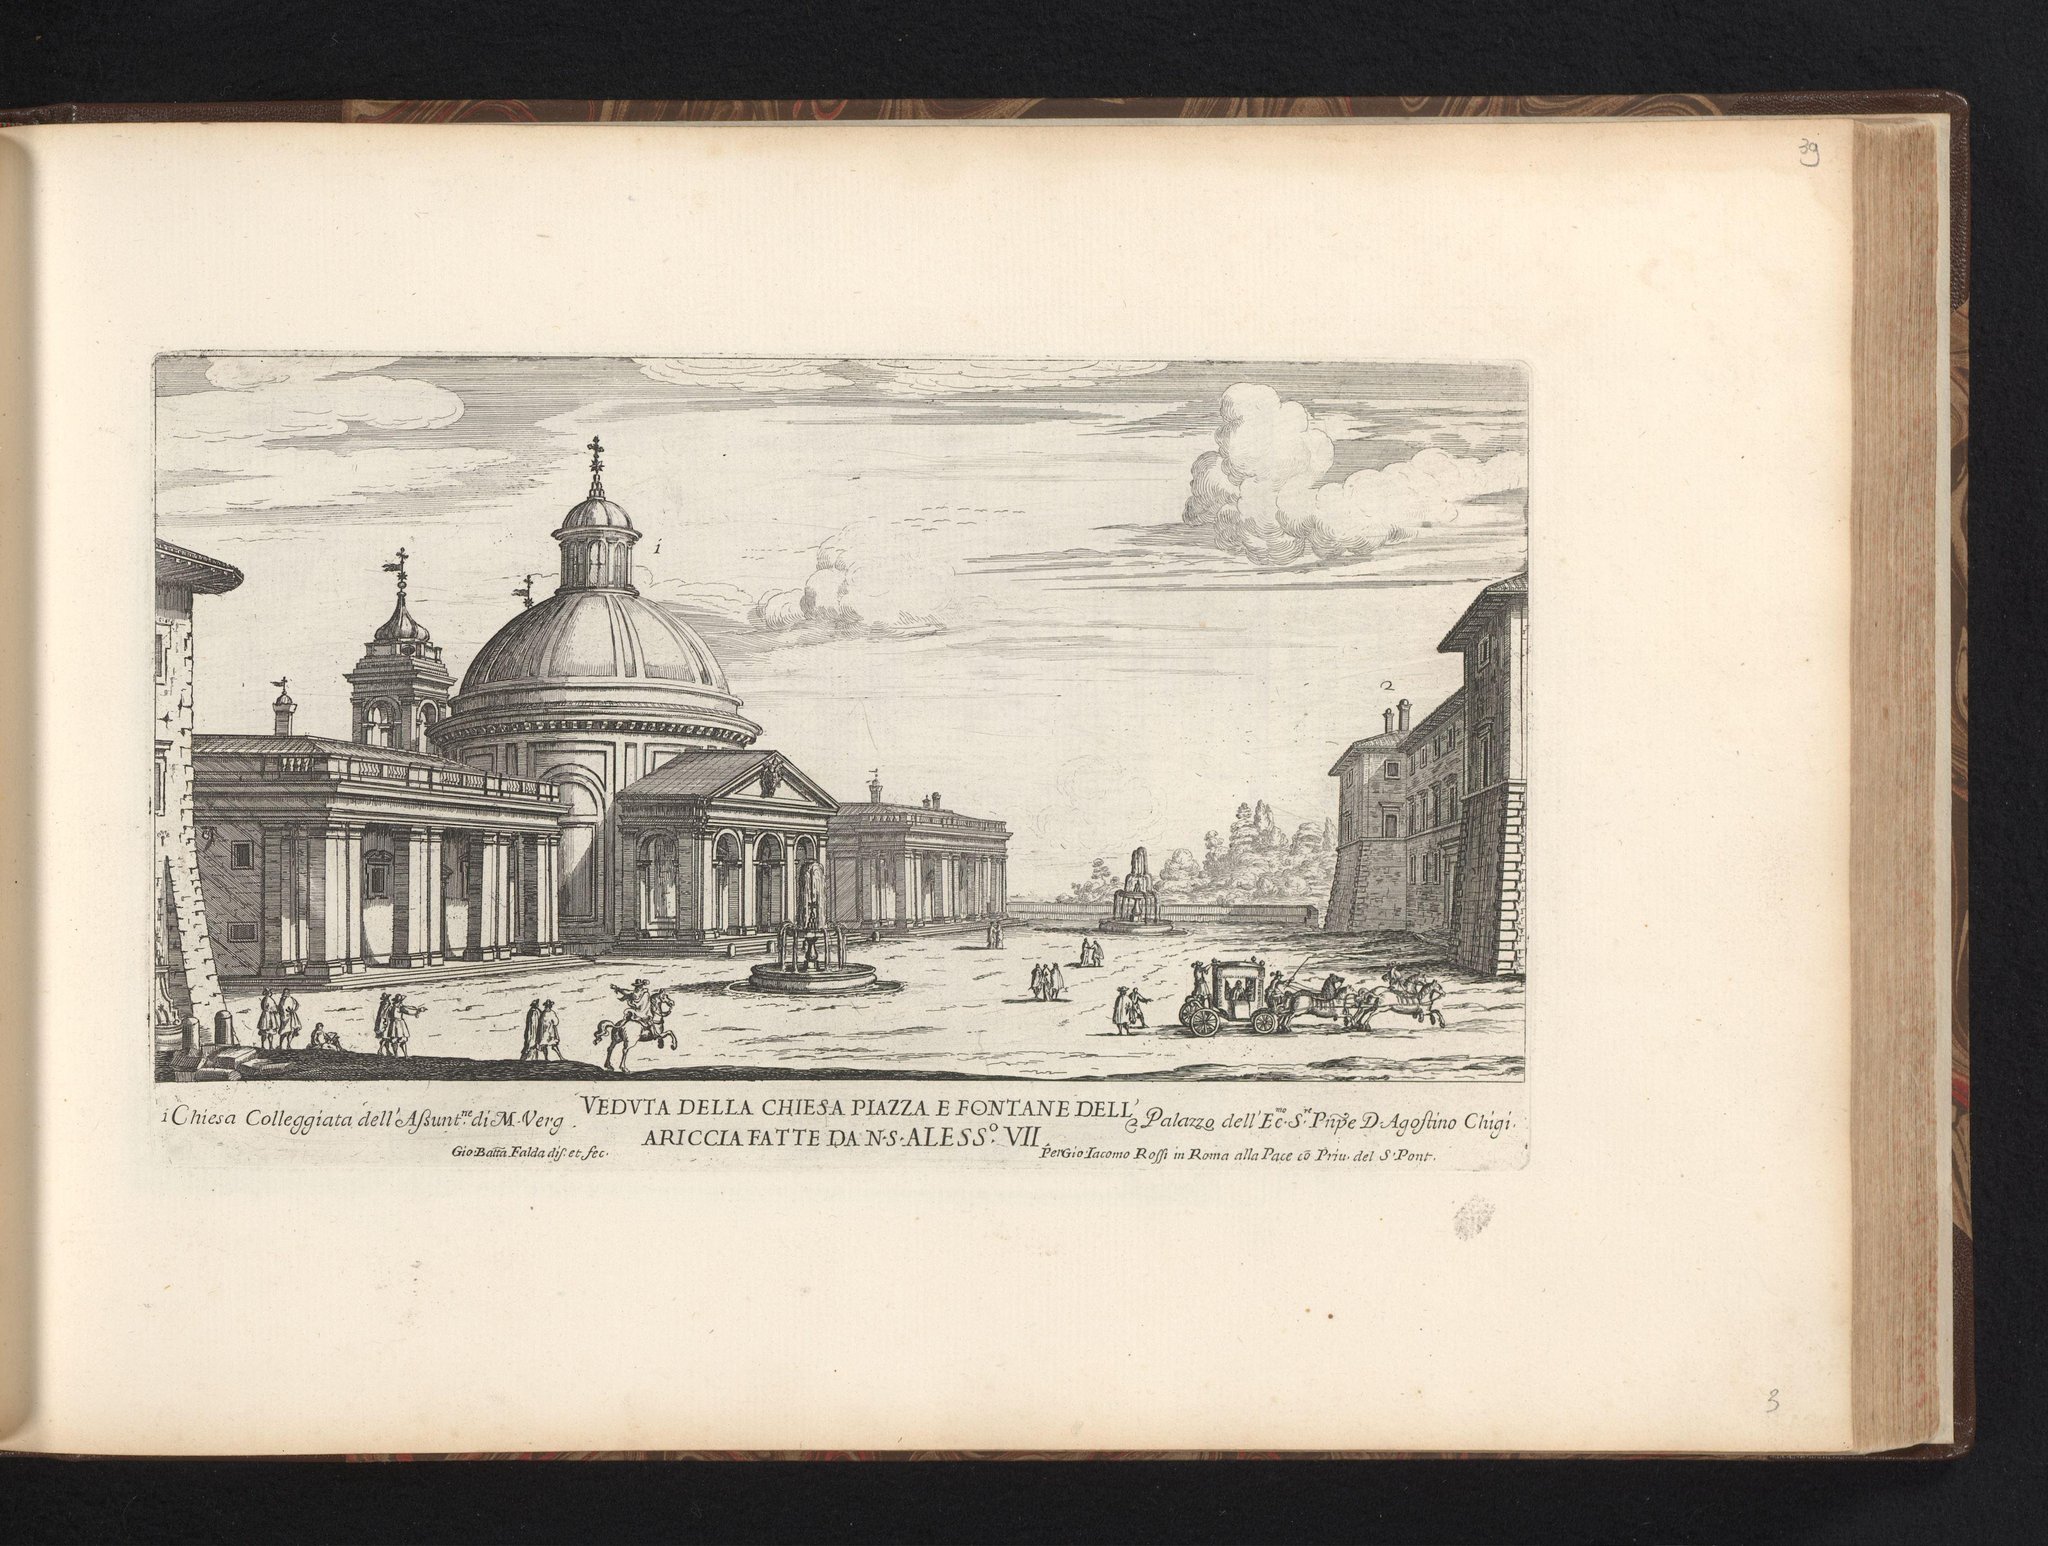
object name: album leaf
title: Il secondo libro del novo teatro delle fabriche, et edificii, fatte fare in Roma, e fuori di Roma dalla santita di nostro signore papa Alessandro VI (...) (libro secondo)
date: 1665-1667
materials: paper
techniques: etching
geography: italy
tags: square, place, circus, etc., city-view, and landscape with man-made constructions, church (exterior), hôtel, i.e. small palace in city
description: Gezicht op Piazza di Corte te Ariccia, met de kerk de Collegiata di Santa Maria Assunta en het Palazzo Chigi. Titel en lijst met verklarende nummers in de ondermarge. Prent maakt deel uit van een album.